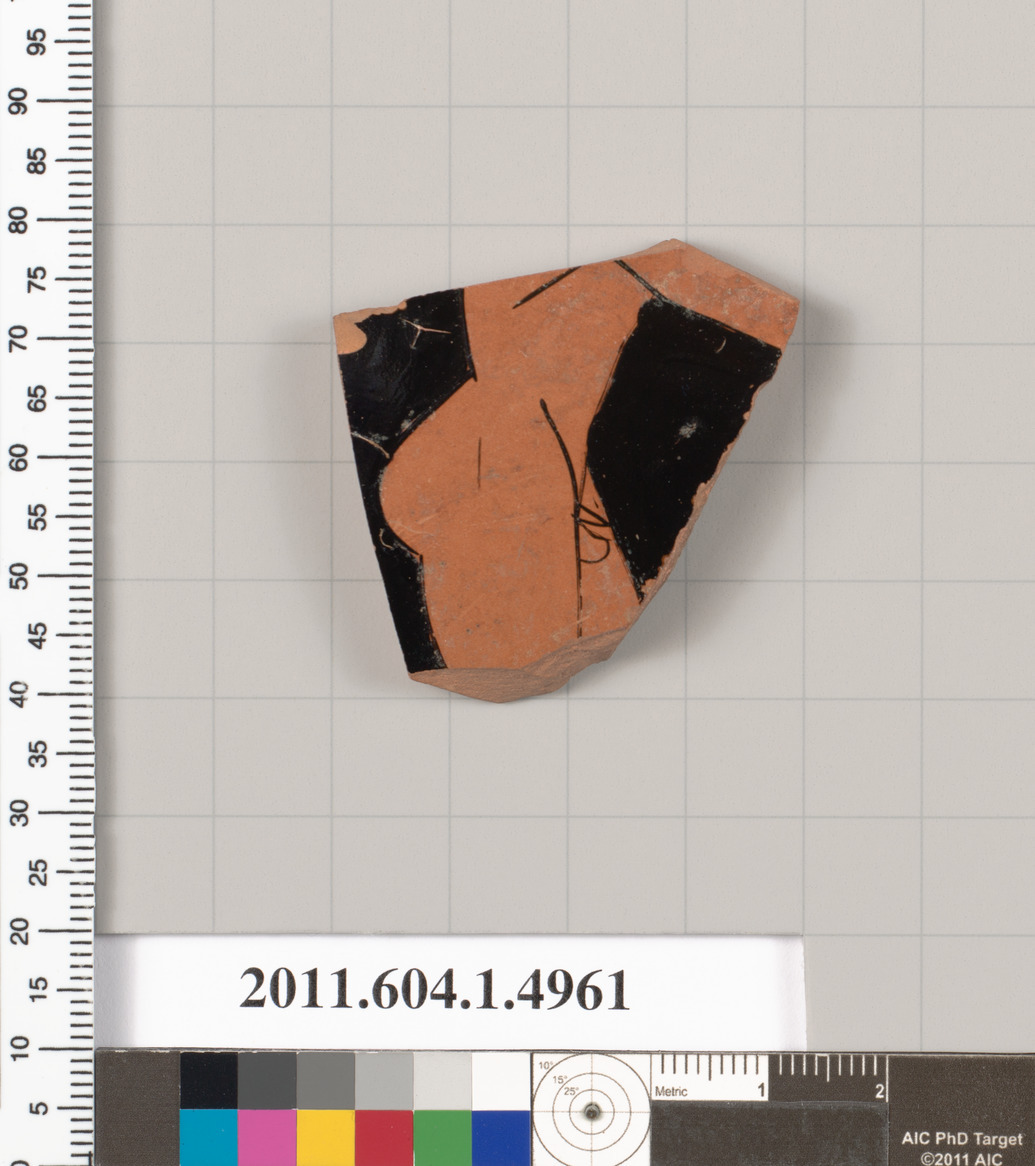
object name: kylix fragment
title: Terracotta fragment of a kylix (drinking cup)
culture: greek, attic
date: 510-480 BCE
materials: terracotta